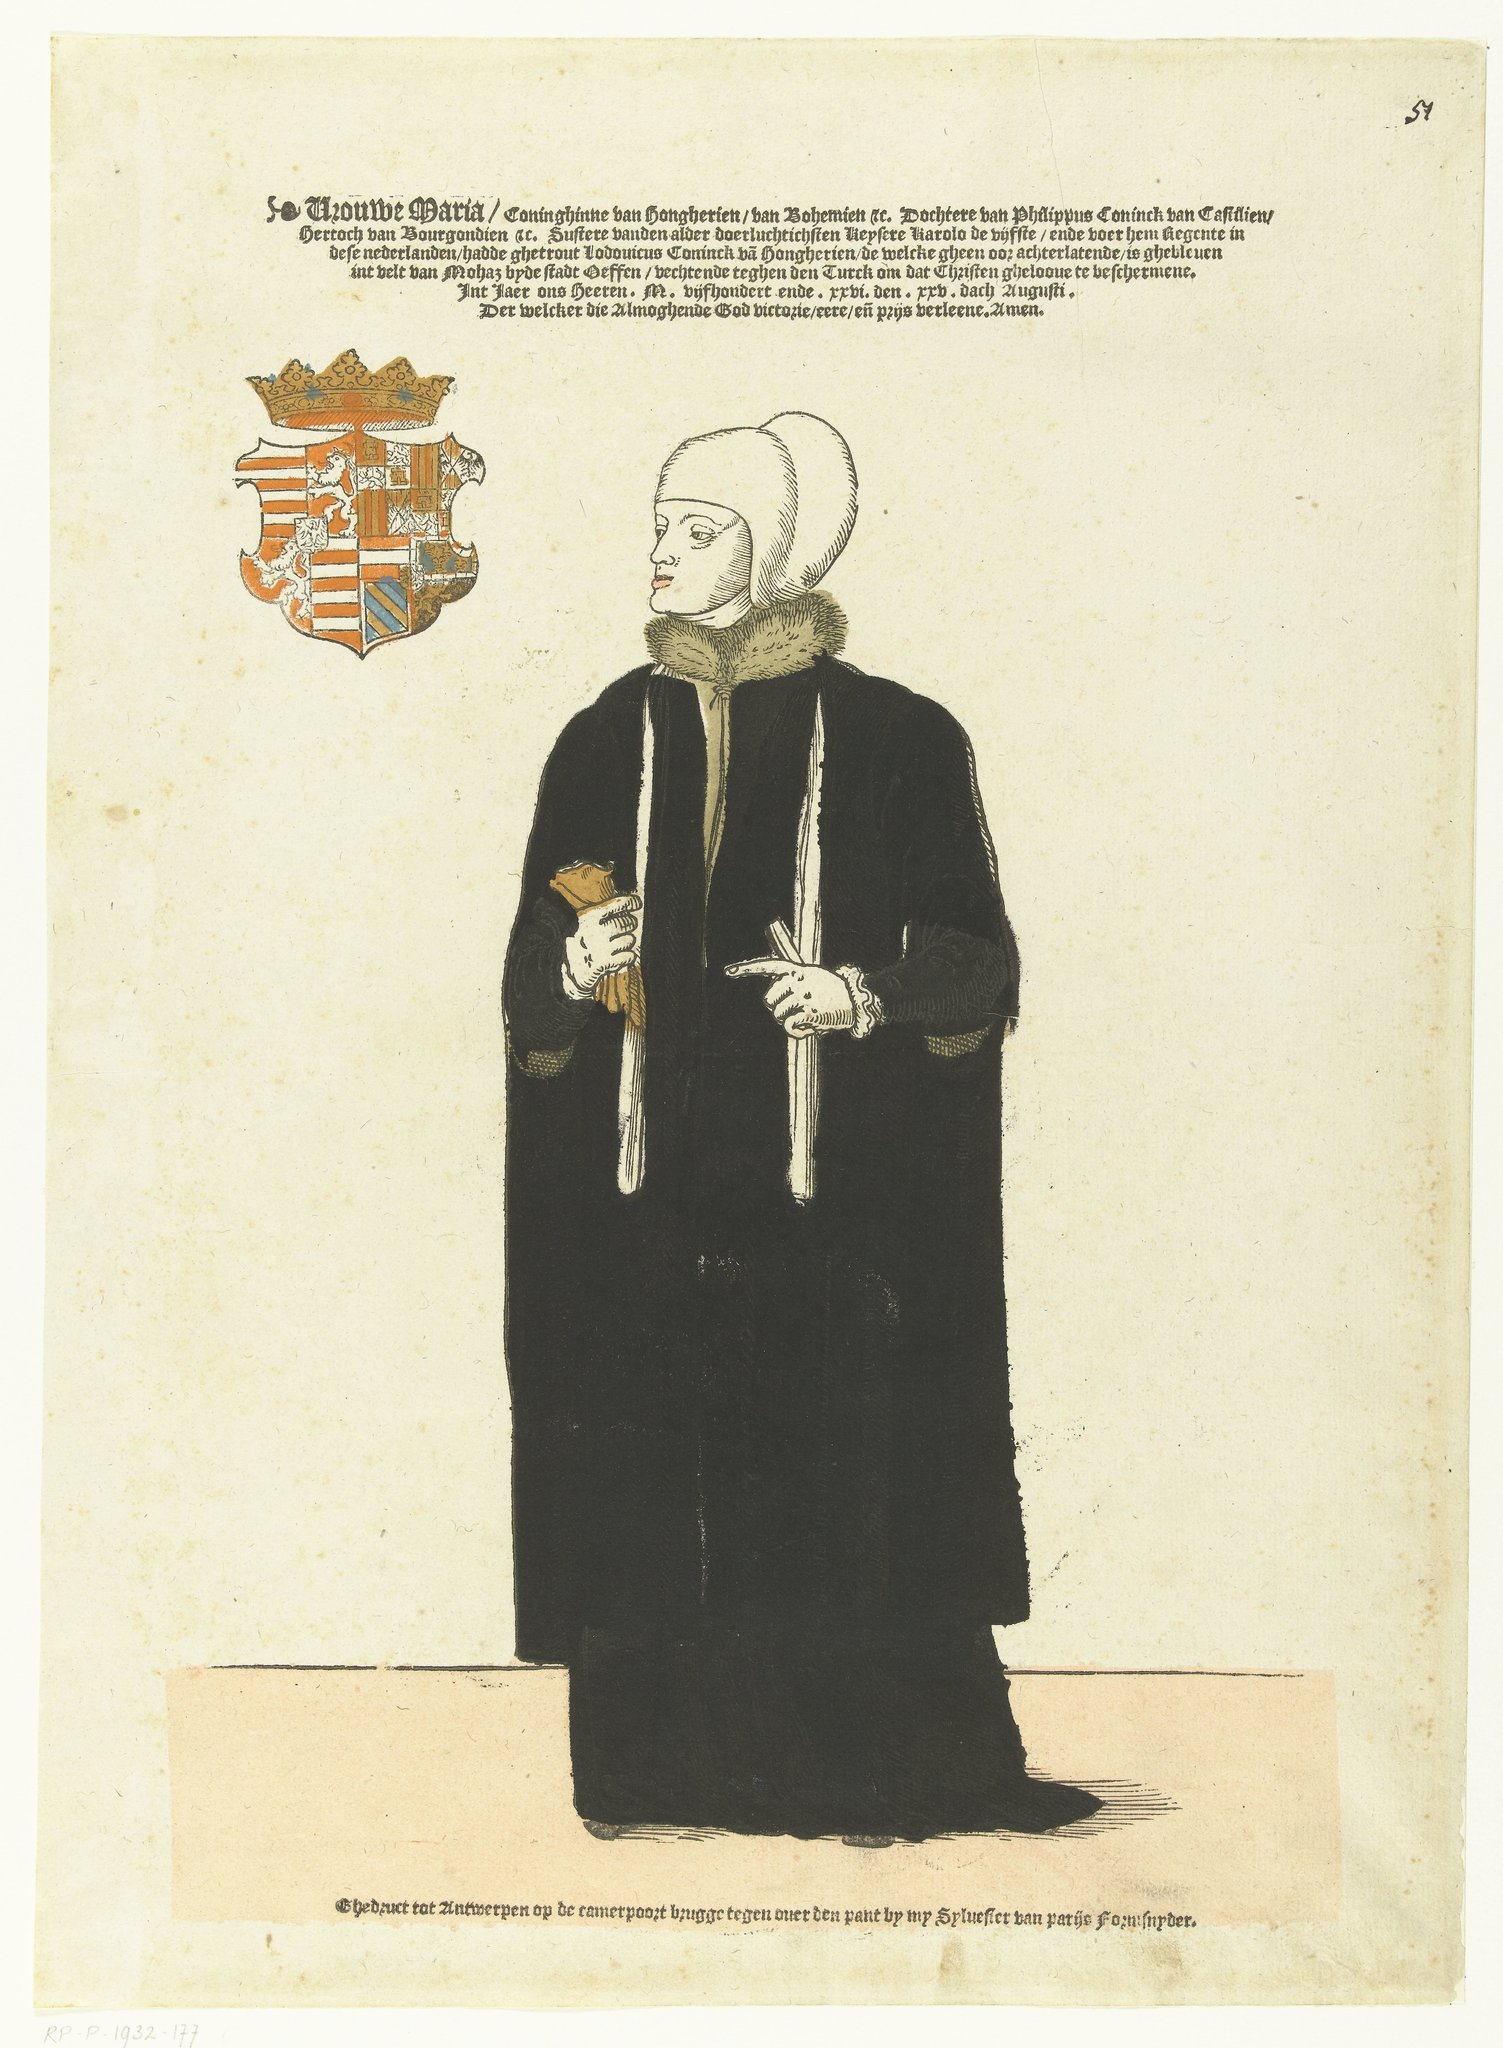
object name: print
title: European Rulers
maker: sylvester van parijs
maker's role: publisher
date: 1538-1558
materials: paper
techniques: hand coloring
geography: antwerp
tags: brussels, maria van hongarije (landvoogdes der nederlanden), historical persons - bb - woman, coat (+ women's clothes), head-gear: cap (+ women's clothes), clothes, costume (+ women's clothes), gloves, mittens, etc. (+ women's clothes), mourning dress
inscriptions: number: ‘57’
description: These woodcuts of European princes, queens and lords are perhaps best compared with today’s collectors cards of soccer players. They are cheap and the people portrayed are celebrities whose exploits are followed with great interest. They are also similar in that they are ephemeral. They are printed by the thousands, are popular for a while and then discarded. Accordingly, such prints are extremely rare nowadays.